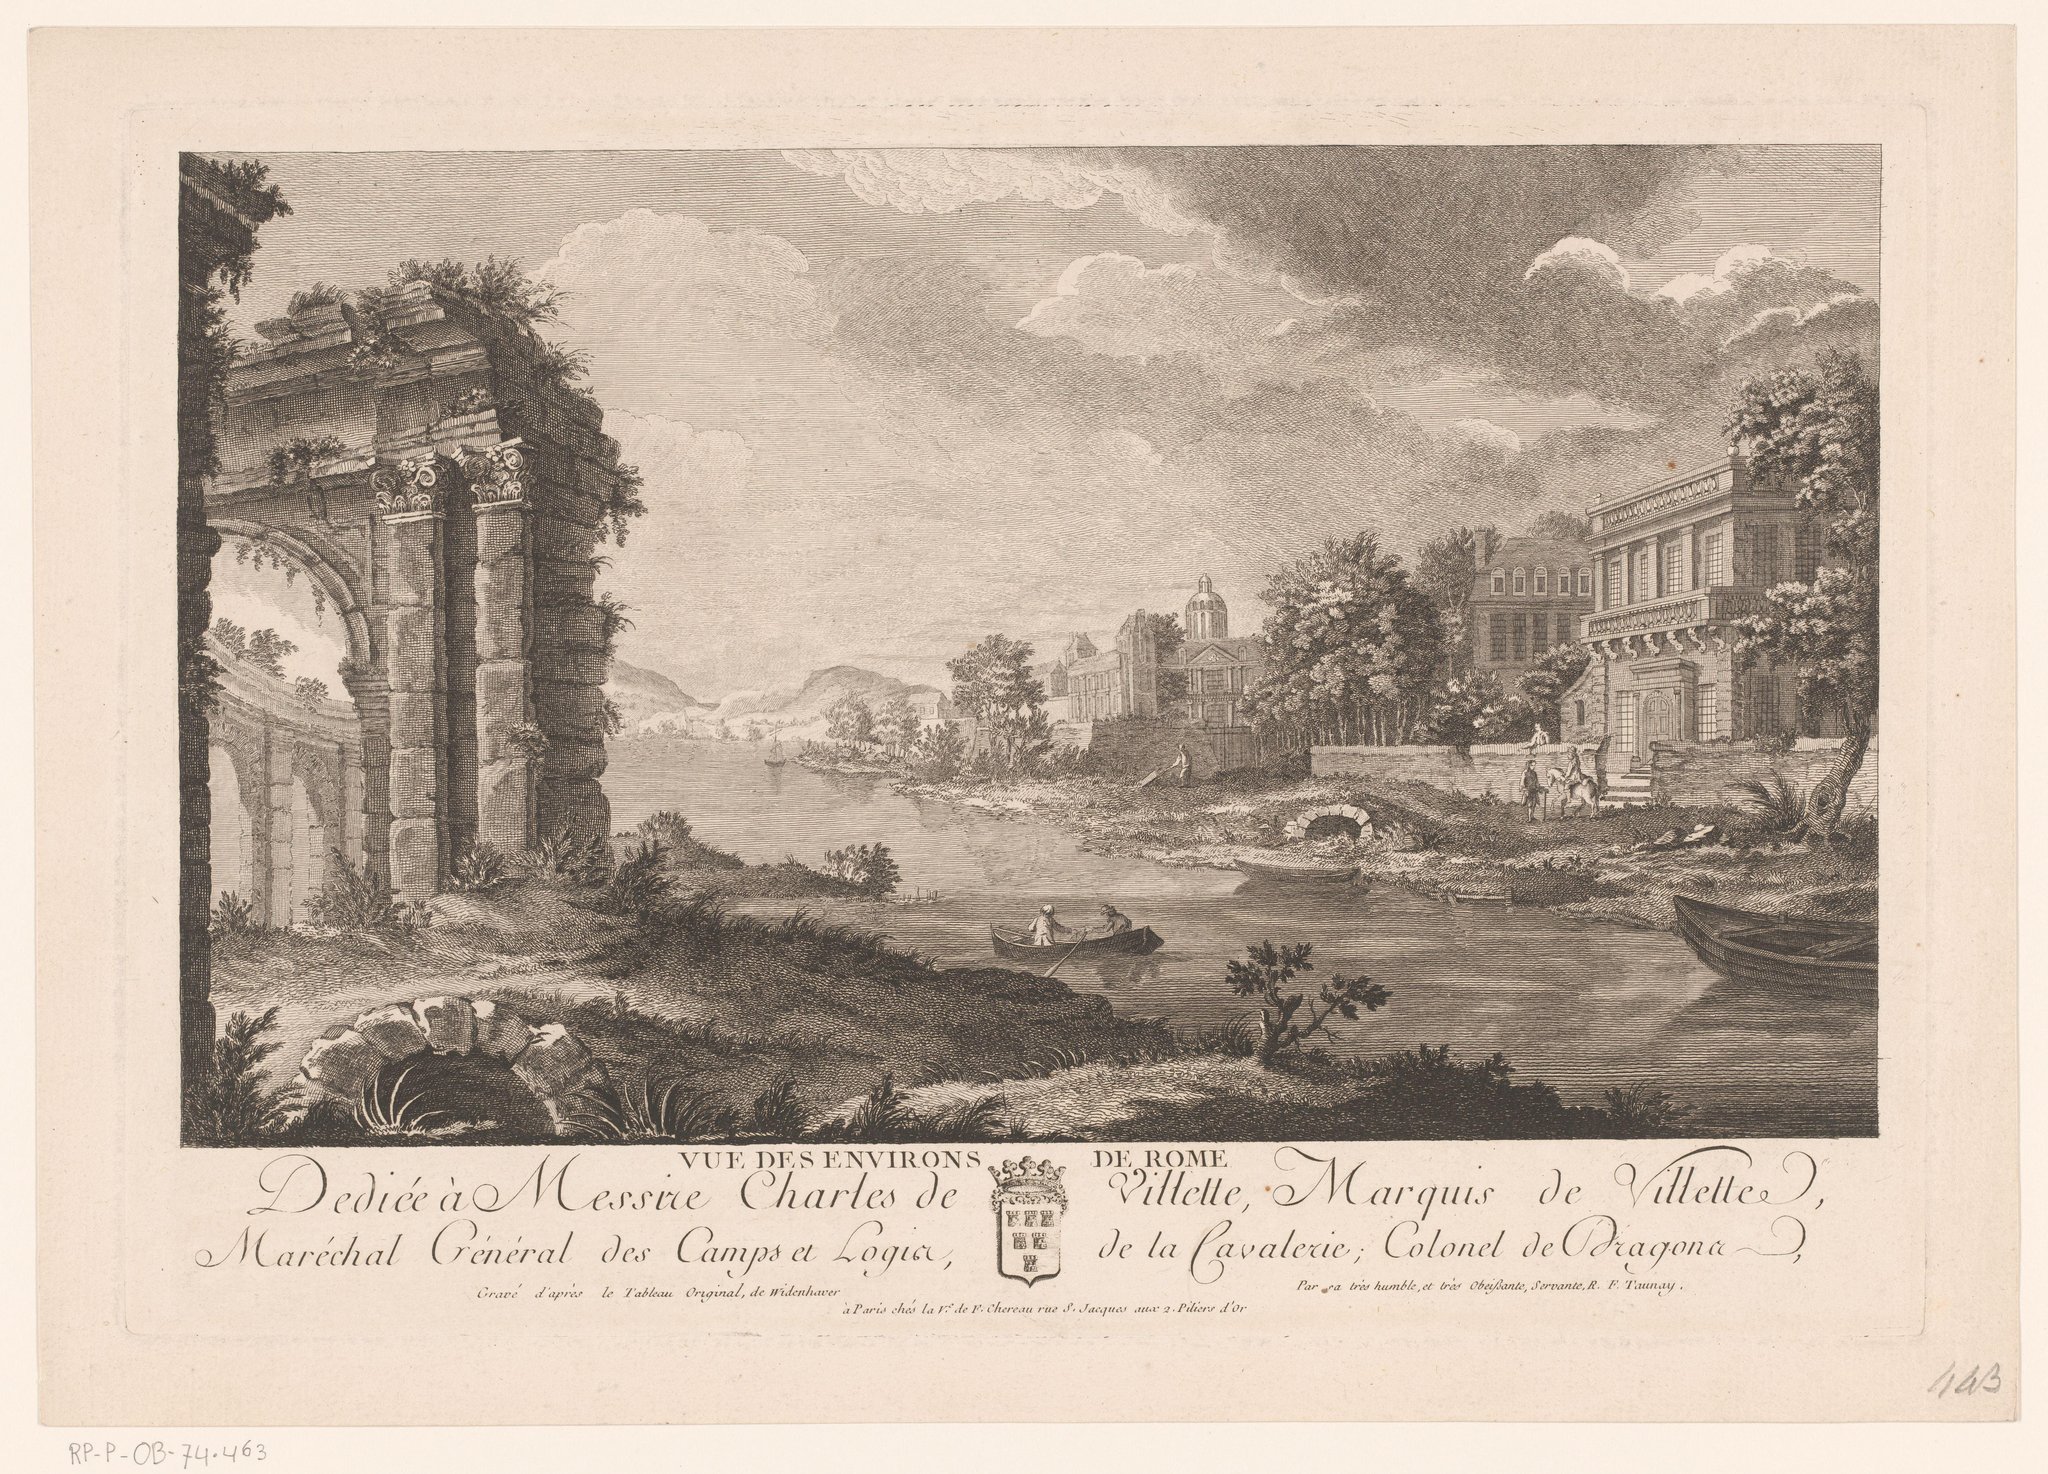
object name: print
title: Vue des Environs de Rome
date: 1765-1775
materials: paper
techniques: etching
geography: paris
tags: landscapes, rome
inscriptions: collector's mark: Lugt 2228